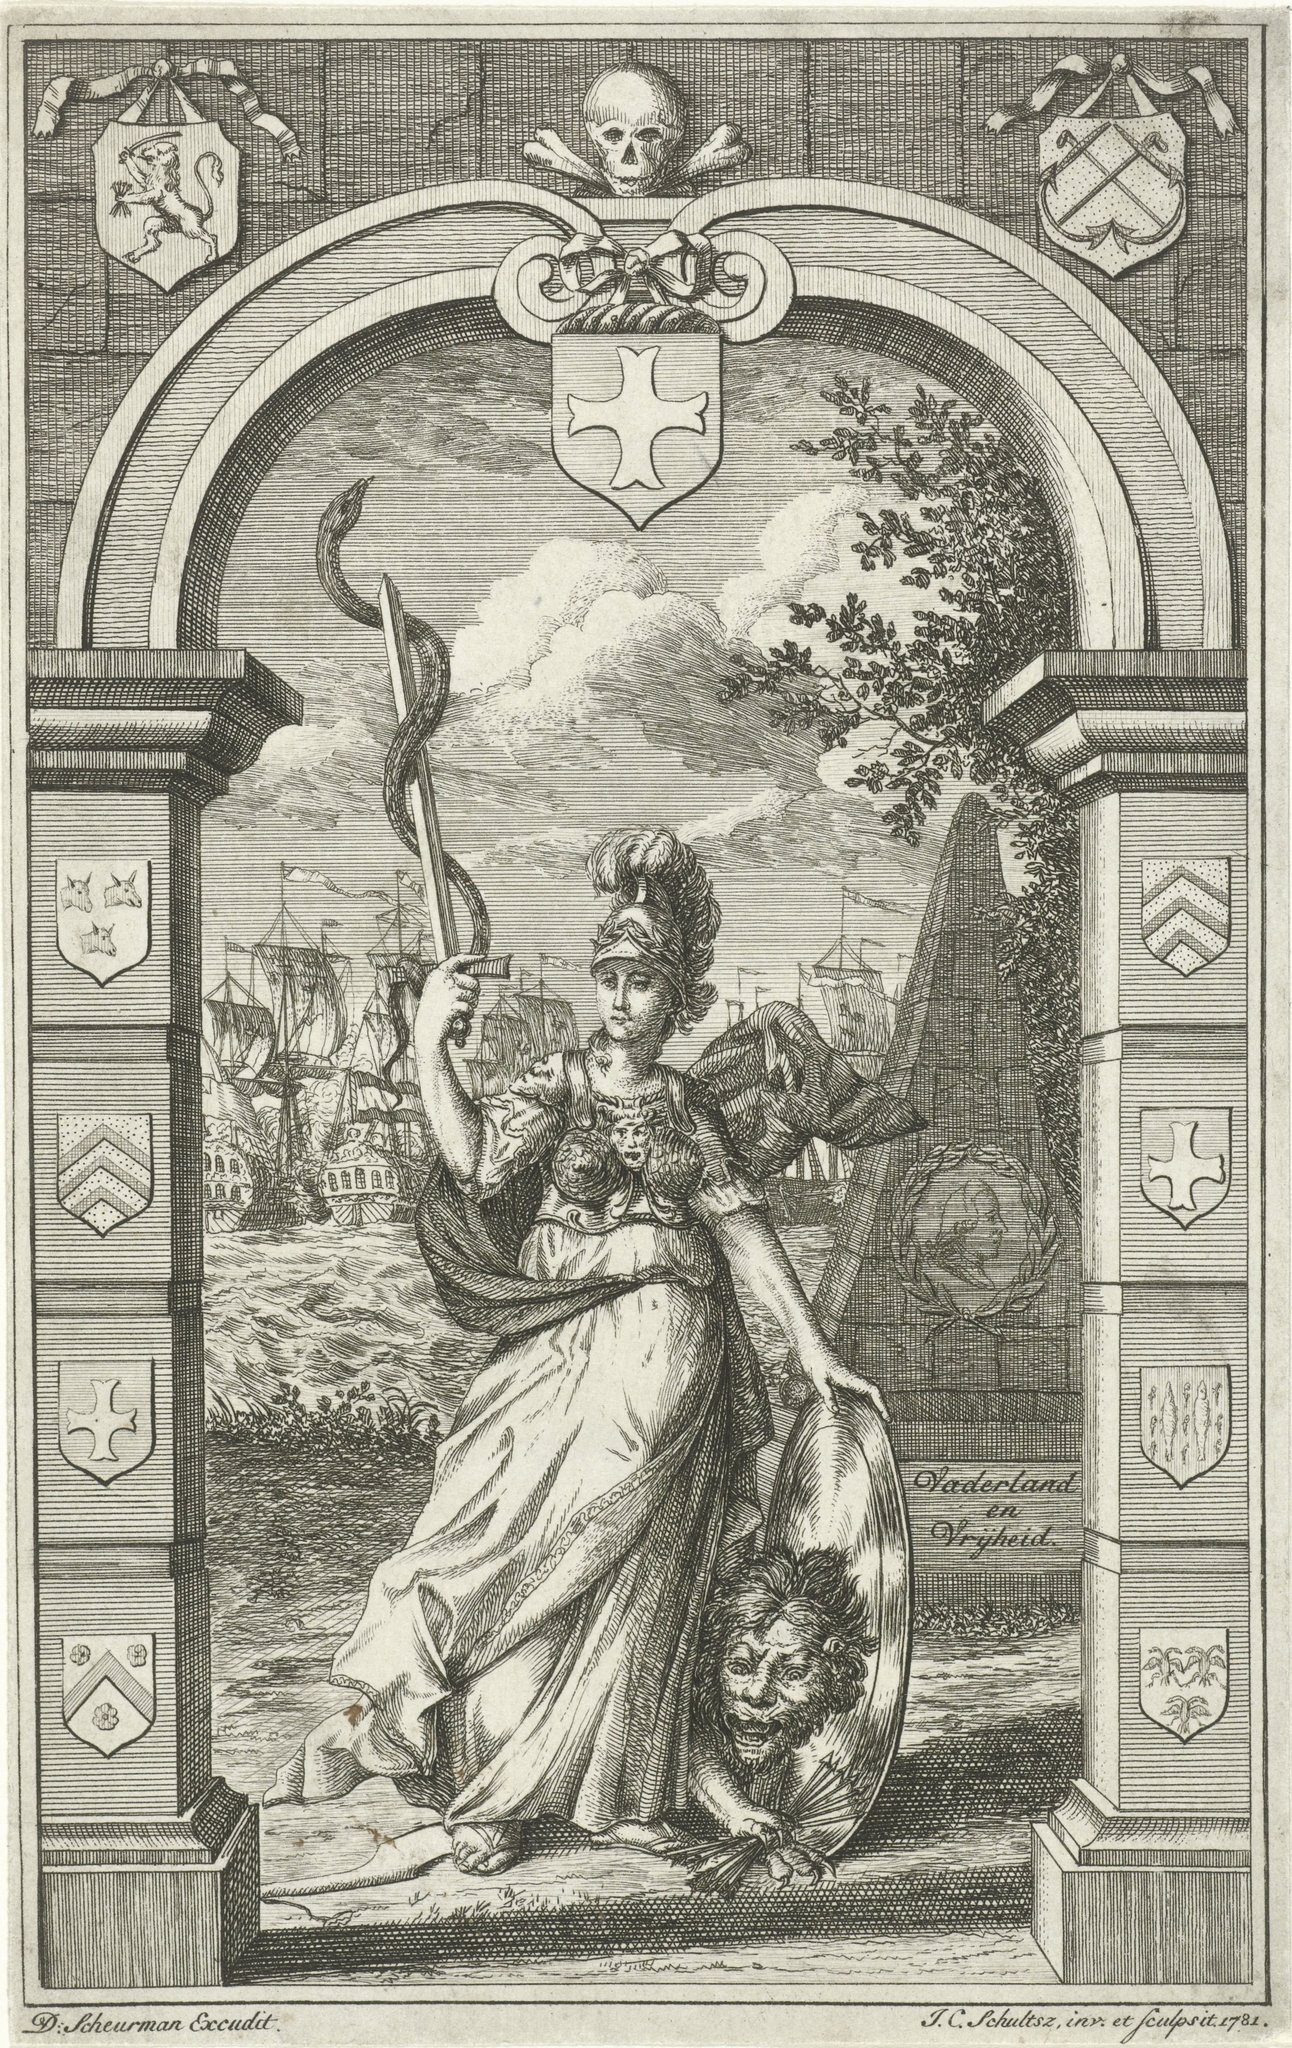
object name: print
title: Allegorie op de dood van Bentinck, 1781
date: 1781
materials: paper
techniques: engraving, etching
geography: amsterdam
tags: amsterdam, battle (+ naval force), freedom, liberty; 'libertà' (ripa) (+ abstract concept represented by female figure)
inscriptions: collector's mark: Lugt 2166, collector's mark: Lugt 2760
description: Allegorie op het overlijden van Wolter Jan Gerrit baron Bentinck op 23/24 augustus en begraven op 28 augustus 1781 in de Nieuwe Kerk te Amsterdam. De Nederlandse Vrijheid staande in een boog met centraal bovenin het wapen van Bentinck, op de achtergrond een piramide met portret van Bentinck, daarachter de Zeeslag bij Doggersbank.